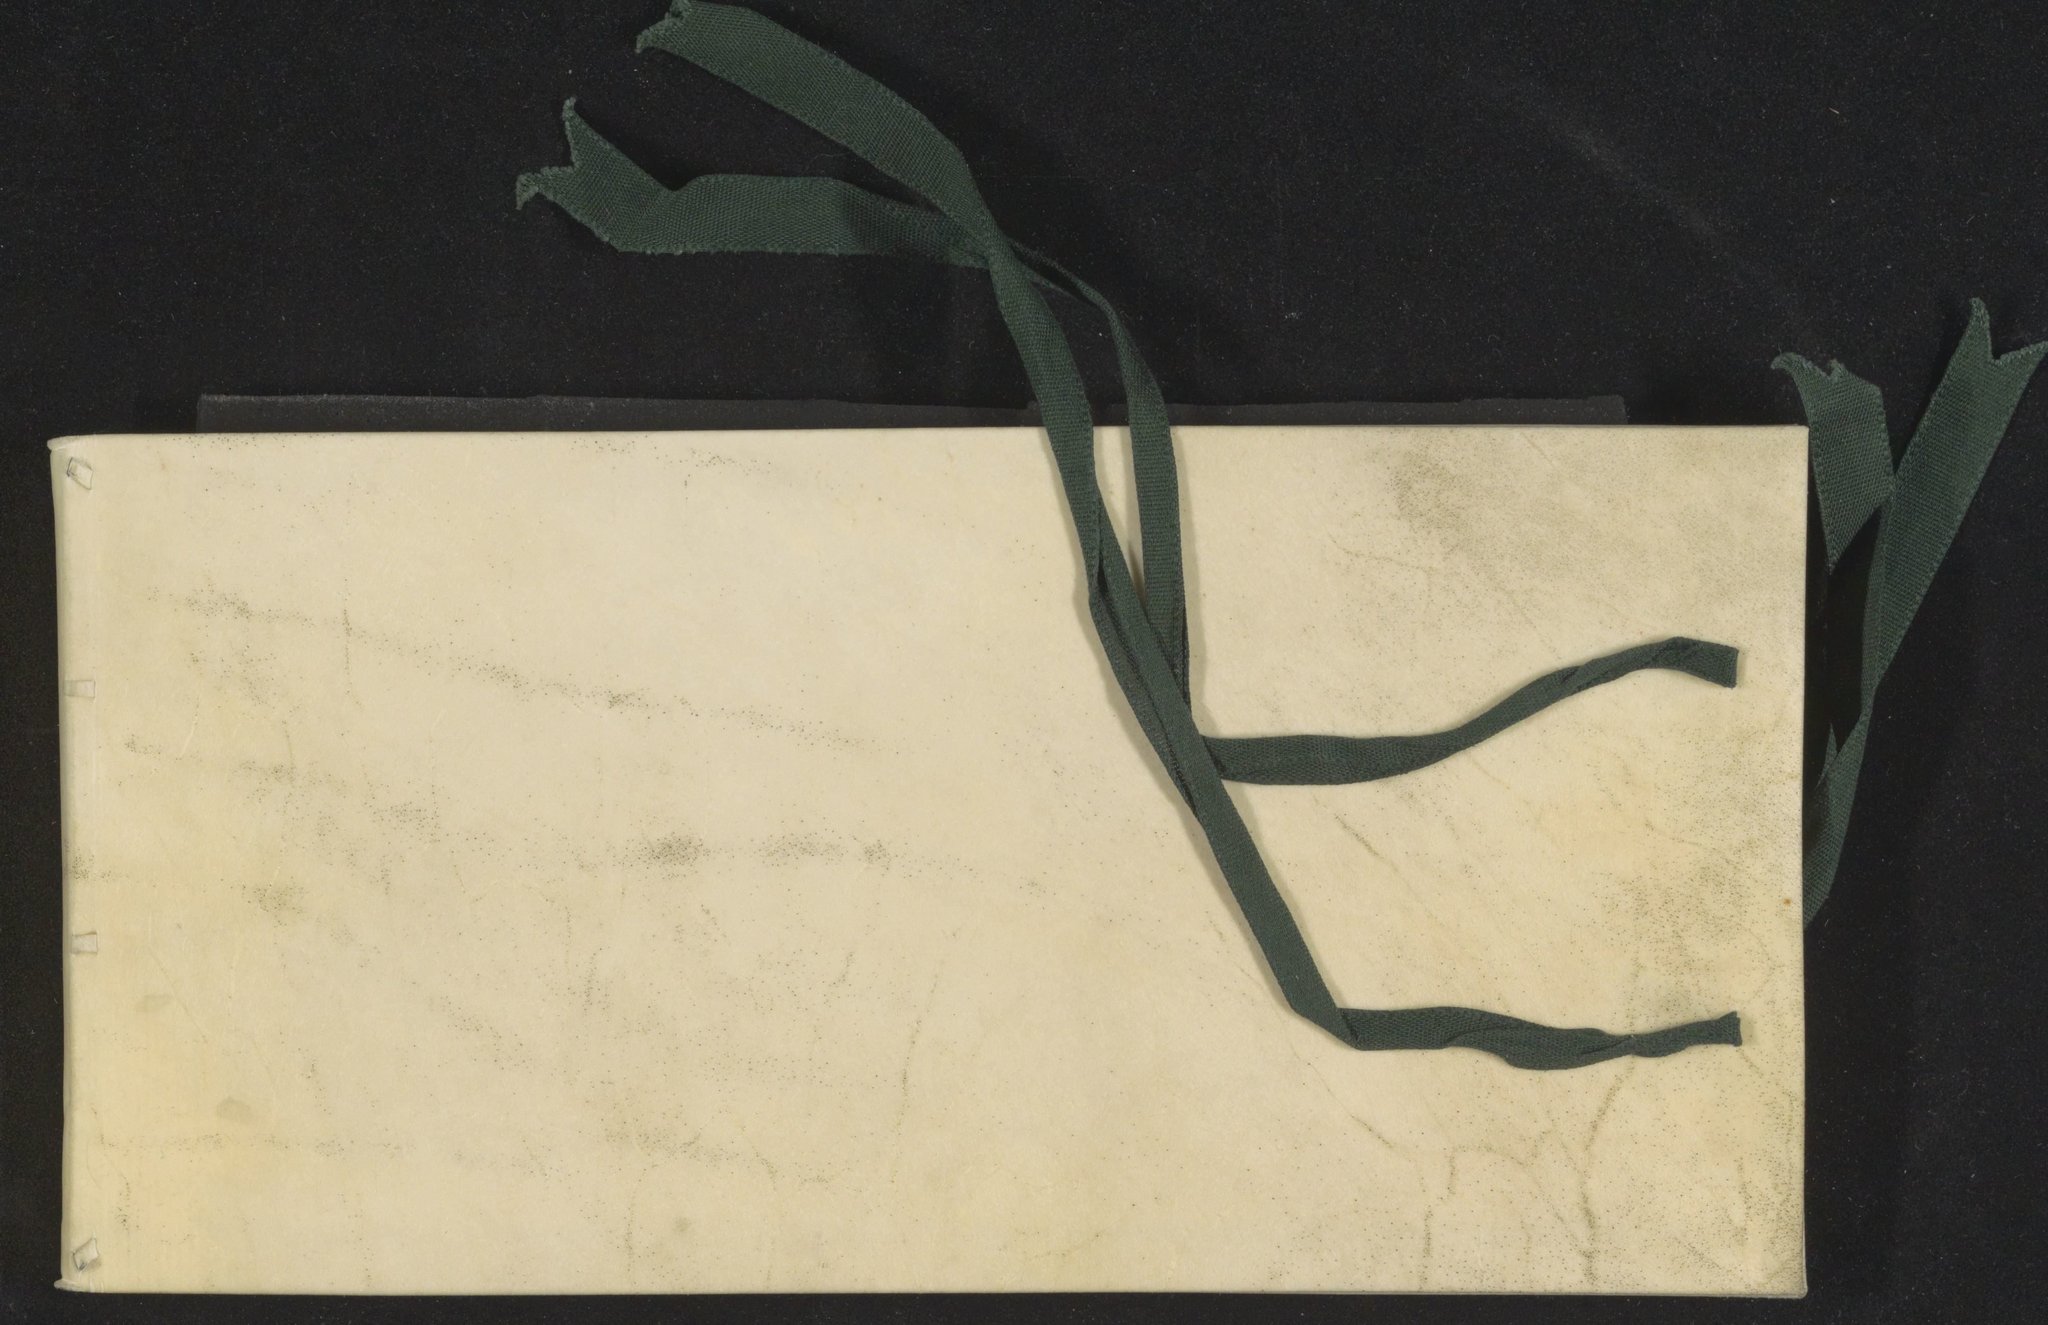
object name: prentrecueil, prentenalbum, prentalbum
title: Album met voorstellingen van viervoetige dieren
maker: eduwart van hoeswinckel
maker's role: publisher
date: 1583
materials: paper, parchment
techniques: bookbinding, engraving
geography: antwerp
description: Album met een serie over viervoetige dieren met de titel Animalium Quadrupedum Omnis Generis Verae et Artificiosissimae Delineationes, bestaande uit een titelprent en 20 prenten, in een perkamenten band.